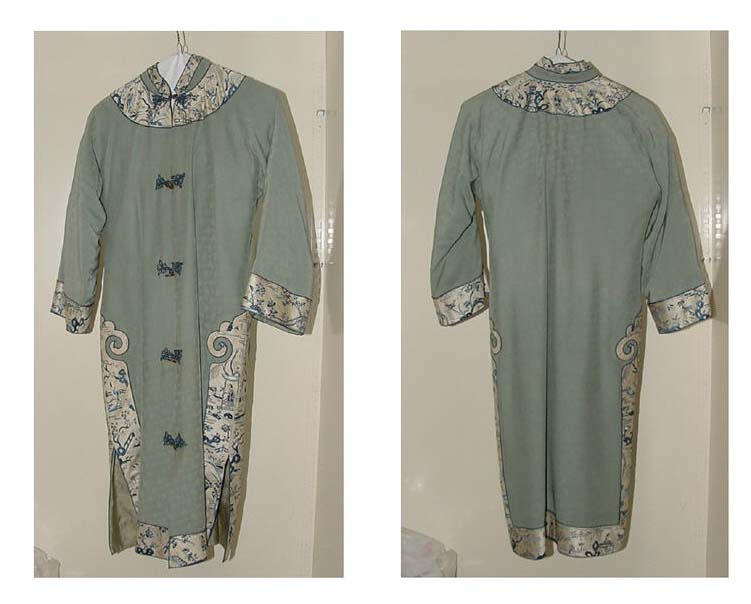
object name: coat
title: Coat with Auspicious Characters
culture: chinese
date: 1930-1939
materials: metal thread, silk